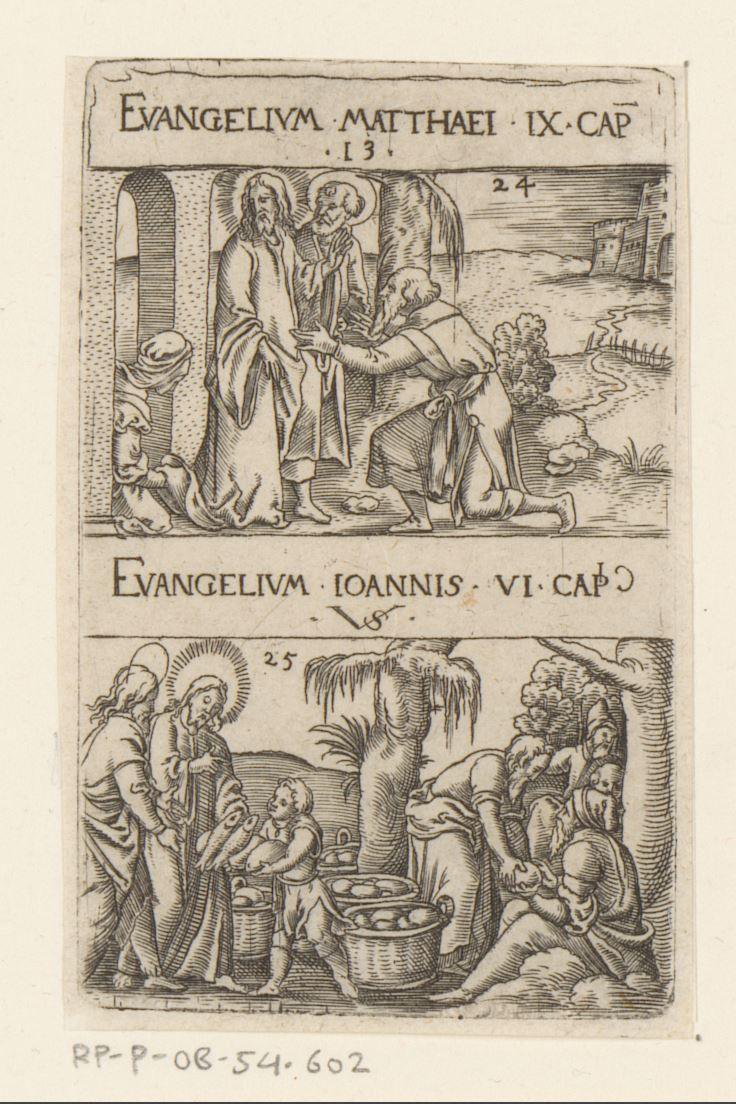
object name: print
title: Opwekking van de dochter van Jaïrus en de vermenigvuldiging van de broden en de vissen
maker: virgilius solis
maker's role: draughtsman, print maker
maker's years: 1514-1562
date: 1524-1562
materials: paper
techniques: engraving, etching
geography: nuremberg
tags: raising of the daughter of jairus, who is lying in bed (matthew 9:18-19, 9:23-26; mark 5:21-24, 5:35-43; luke 8:40-42, 8:49-56), christ and apostles distribute bread and fish among the multitude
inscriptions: collector's mark: Lugt 2228, number: ‘88’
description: Deze prent maakt deel uit van een serie bestaande uit 27 genummerde prenten. De prenten tonen steeds twee evangelische scènes boven elkaar. Alle voorstellingen behalve de bovenste van de eerste prent zijn eveneens afzonderlijk genummerd.